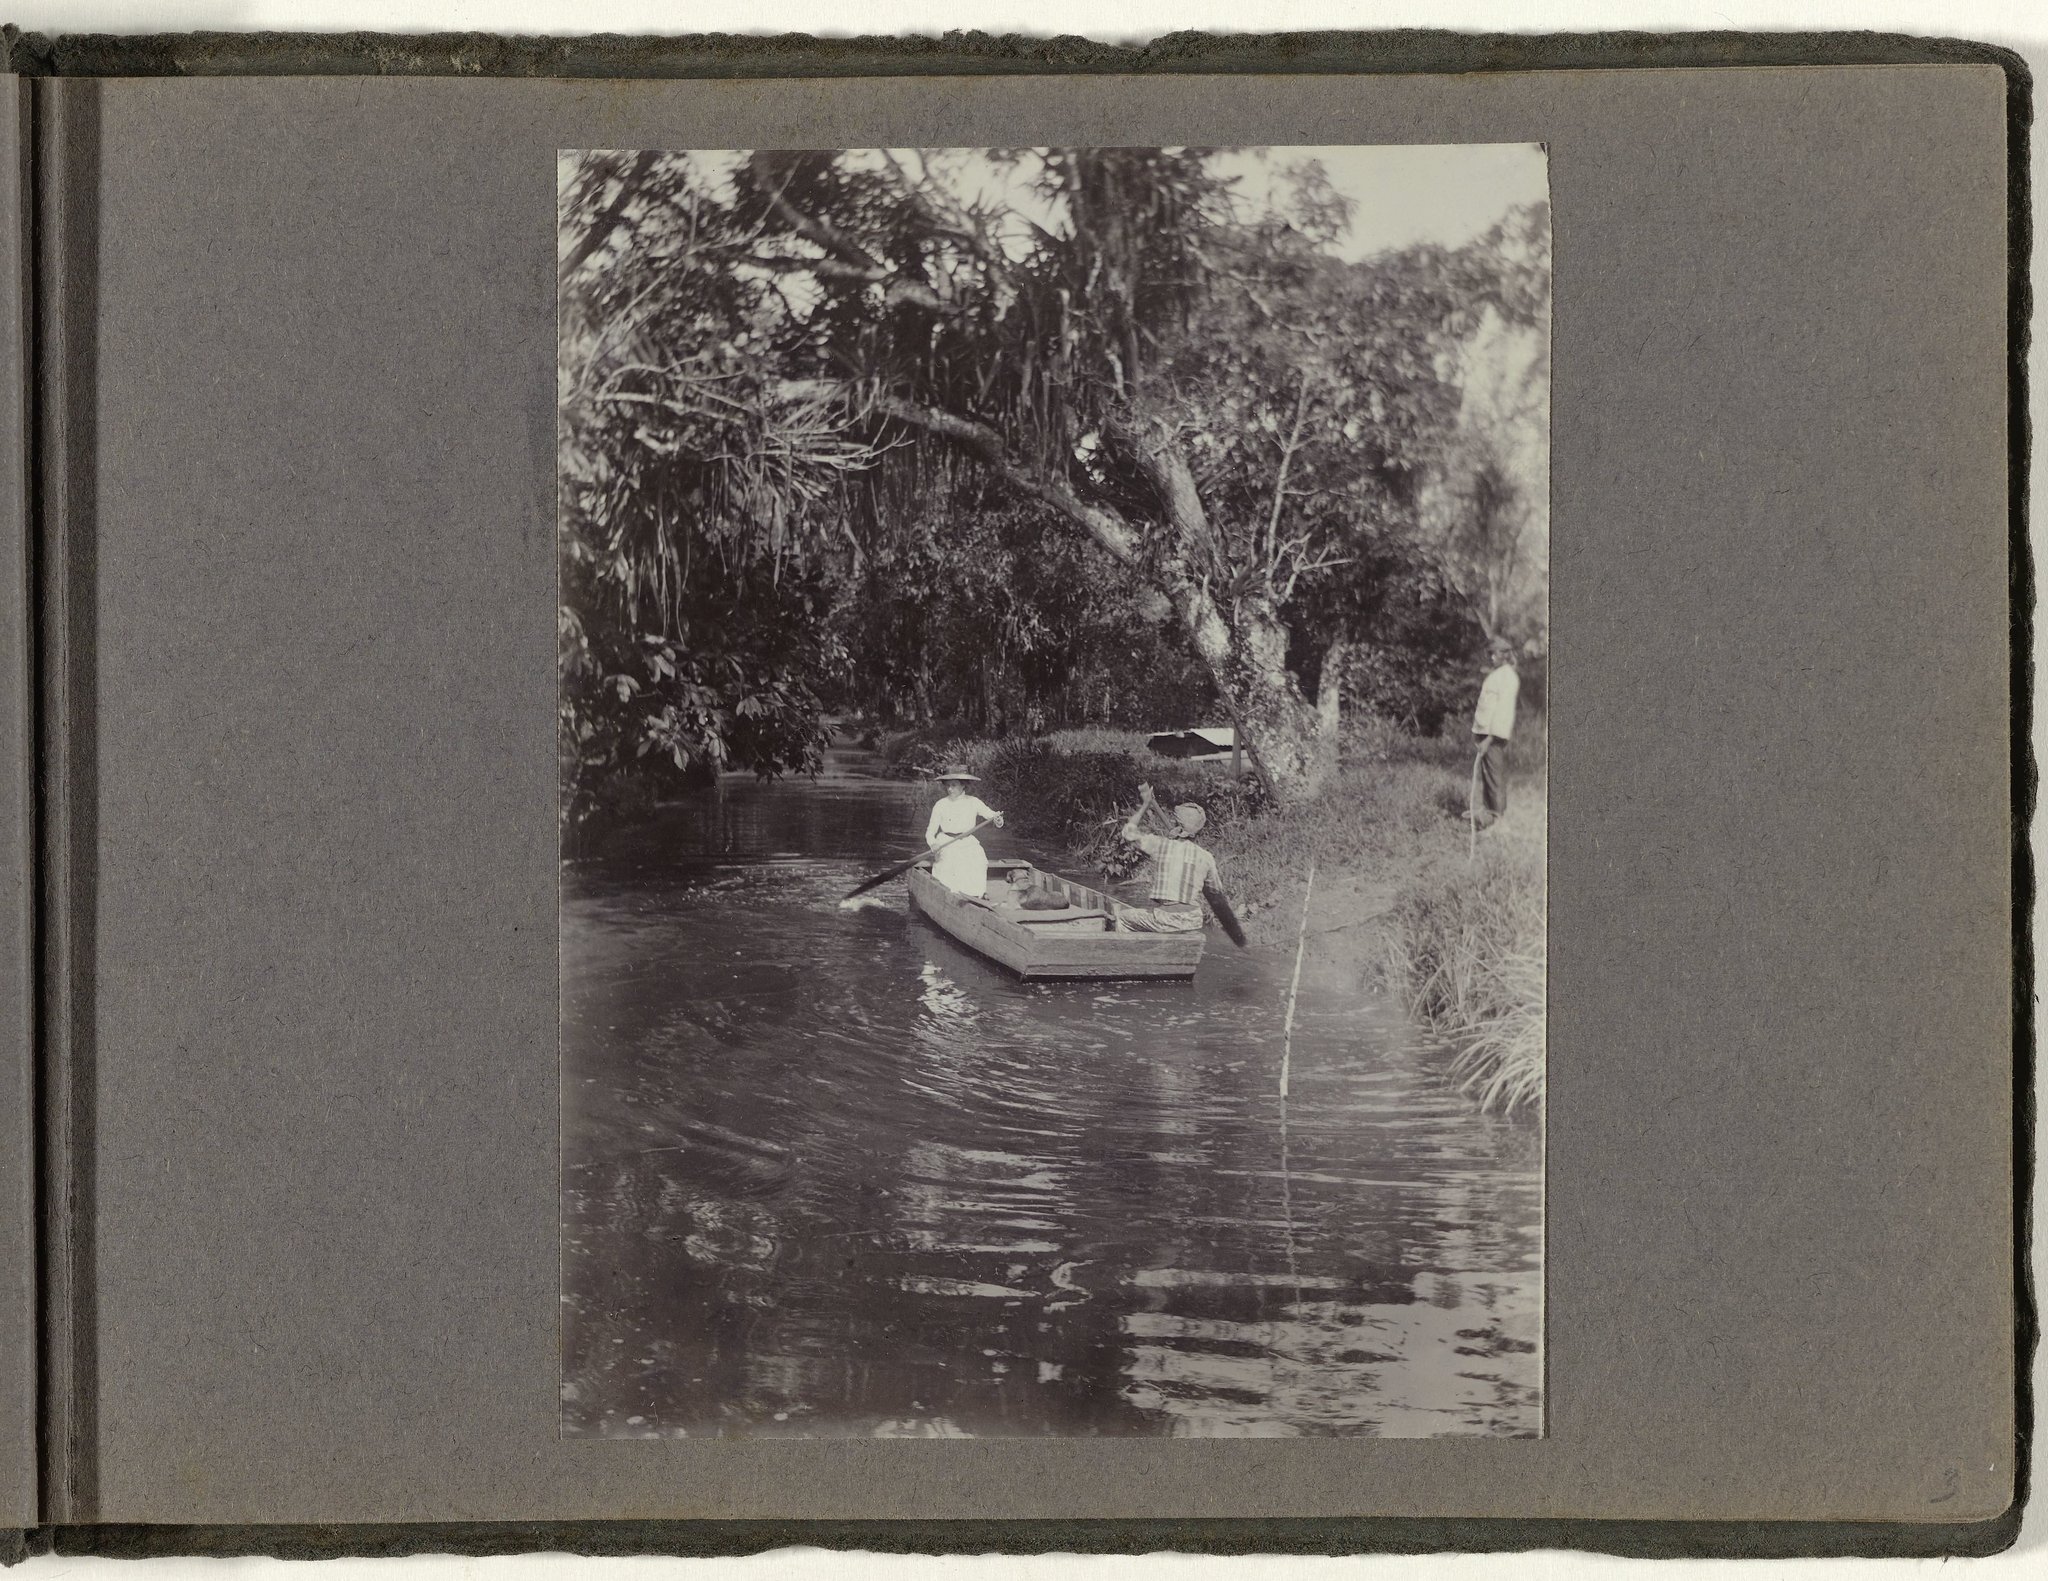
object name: photograph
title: In een bootje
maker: Anonymous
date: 1910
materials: photographic support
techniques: gelatin silver print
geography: suriname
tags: plantation, suriname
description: Europese vrouw in een roeibootje op het water, waarschijnlijk bij plantage Clevia. Onderdeel van het fotoalbum over de familie Gonggrijp op de plantages Clevia en Morgenstond in Suriname rond 1910.